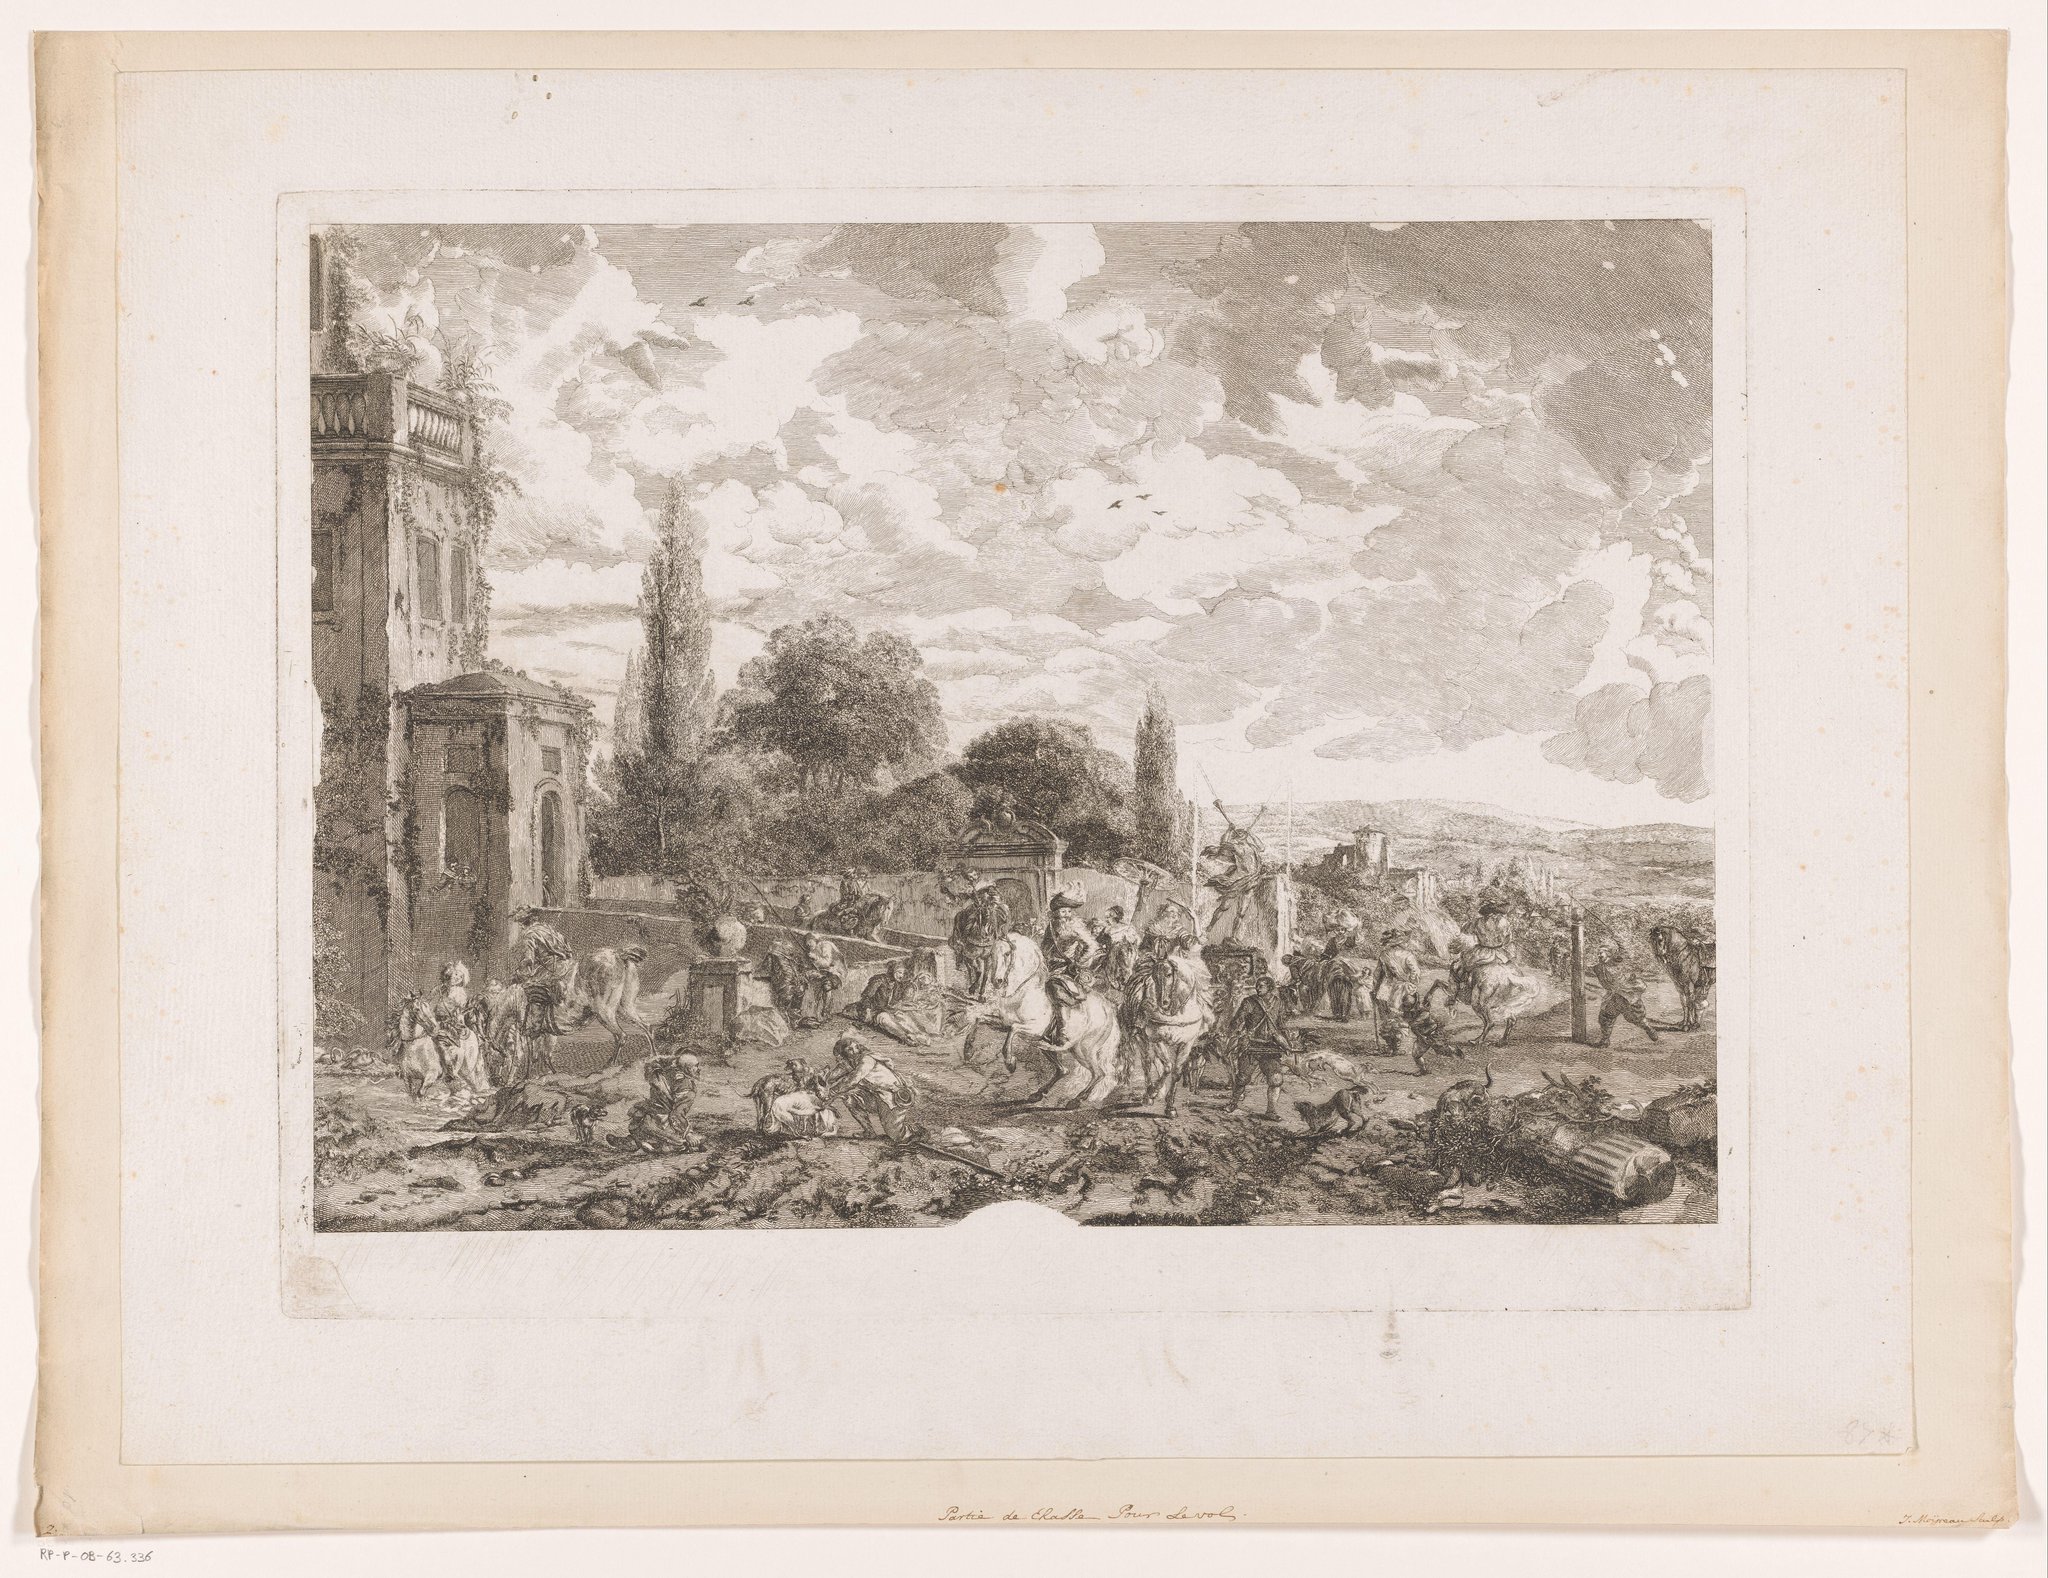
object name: print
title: Vertrekkend jachtgezelschap voor een huis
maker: jean moyreau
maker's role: print maker, publisher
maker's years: 1690-1762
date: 1759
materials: paper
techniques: etching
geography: france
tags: assembling, 'départ pour la chasse'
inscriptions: collector's mark: Lugt 240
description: Maakt deel uit van een serie van 89 prenten te dateren tussen ca. 1733-1762, naar het geschilderde oeuvre van Philips Wouwerman. Dit betreft plaat 87.